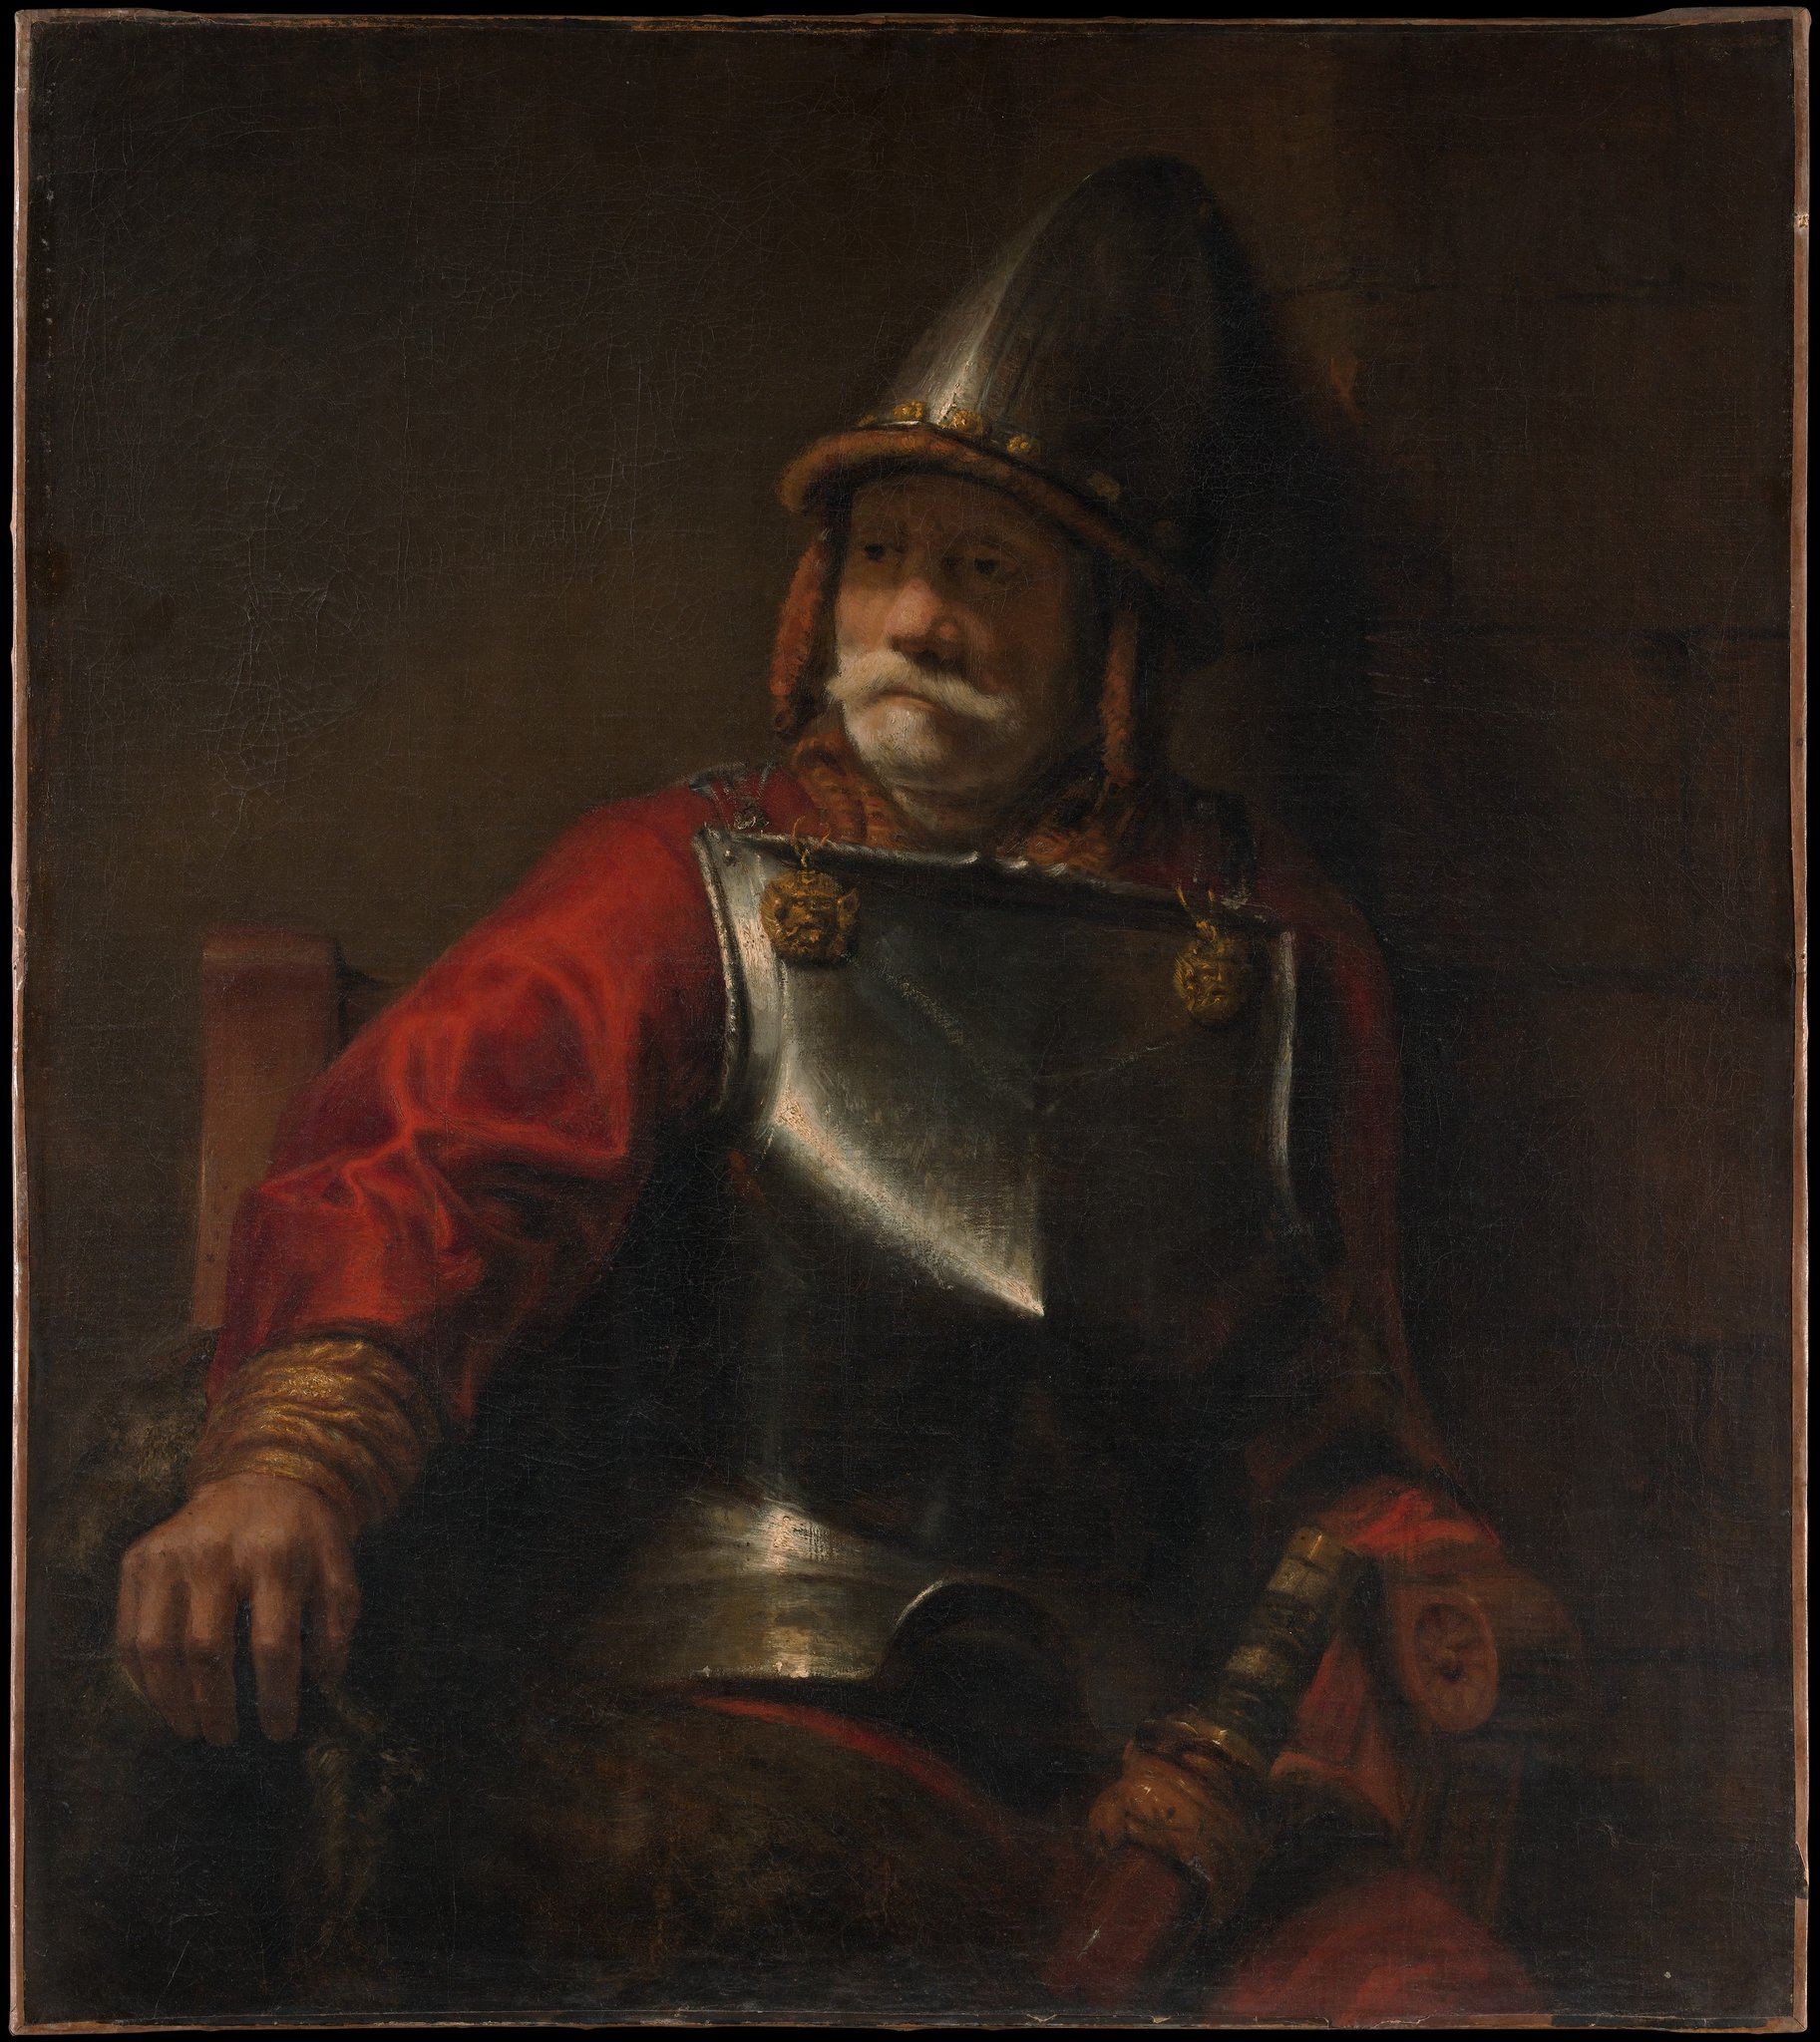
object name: painting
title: Man in Armor (Mars?)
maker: rembrandt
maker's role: artist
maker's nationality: dutch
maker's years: 1606-1669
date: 1625-1674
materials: canvas, oil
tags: armor,men,portraits